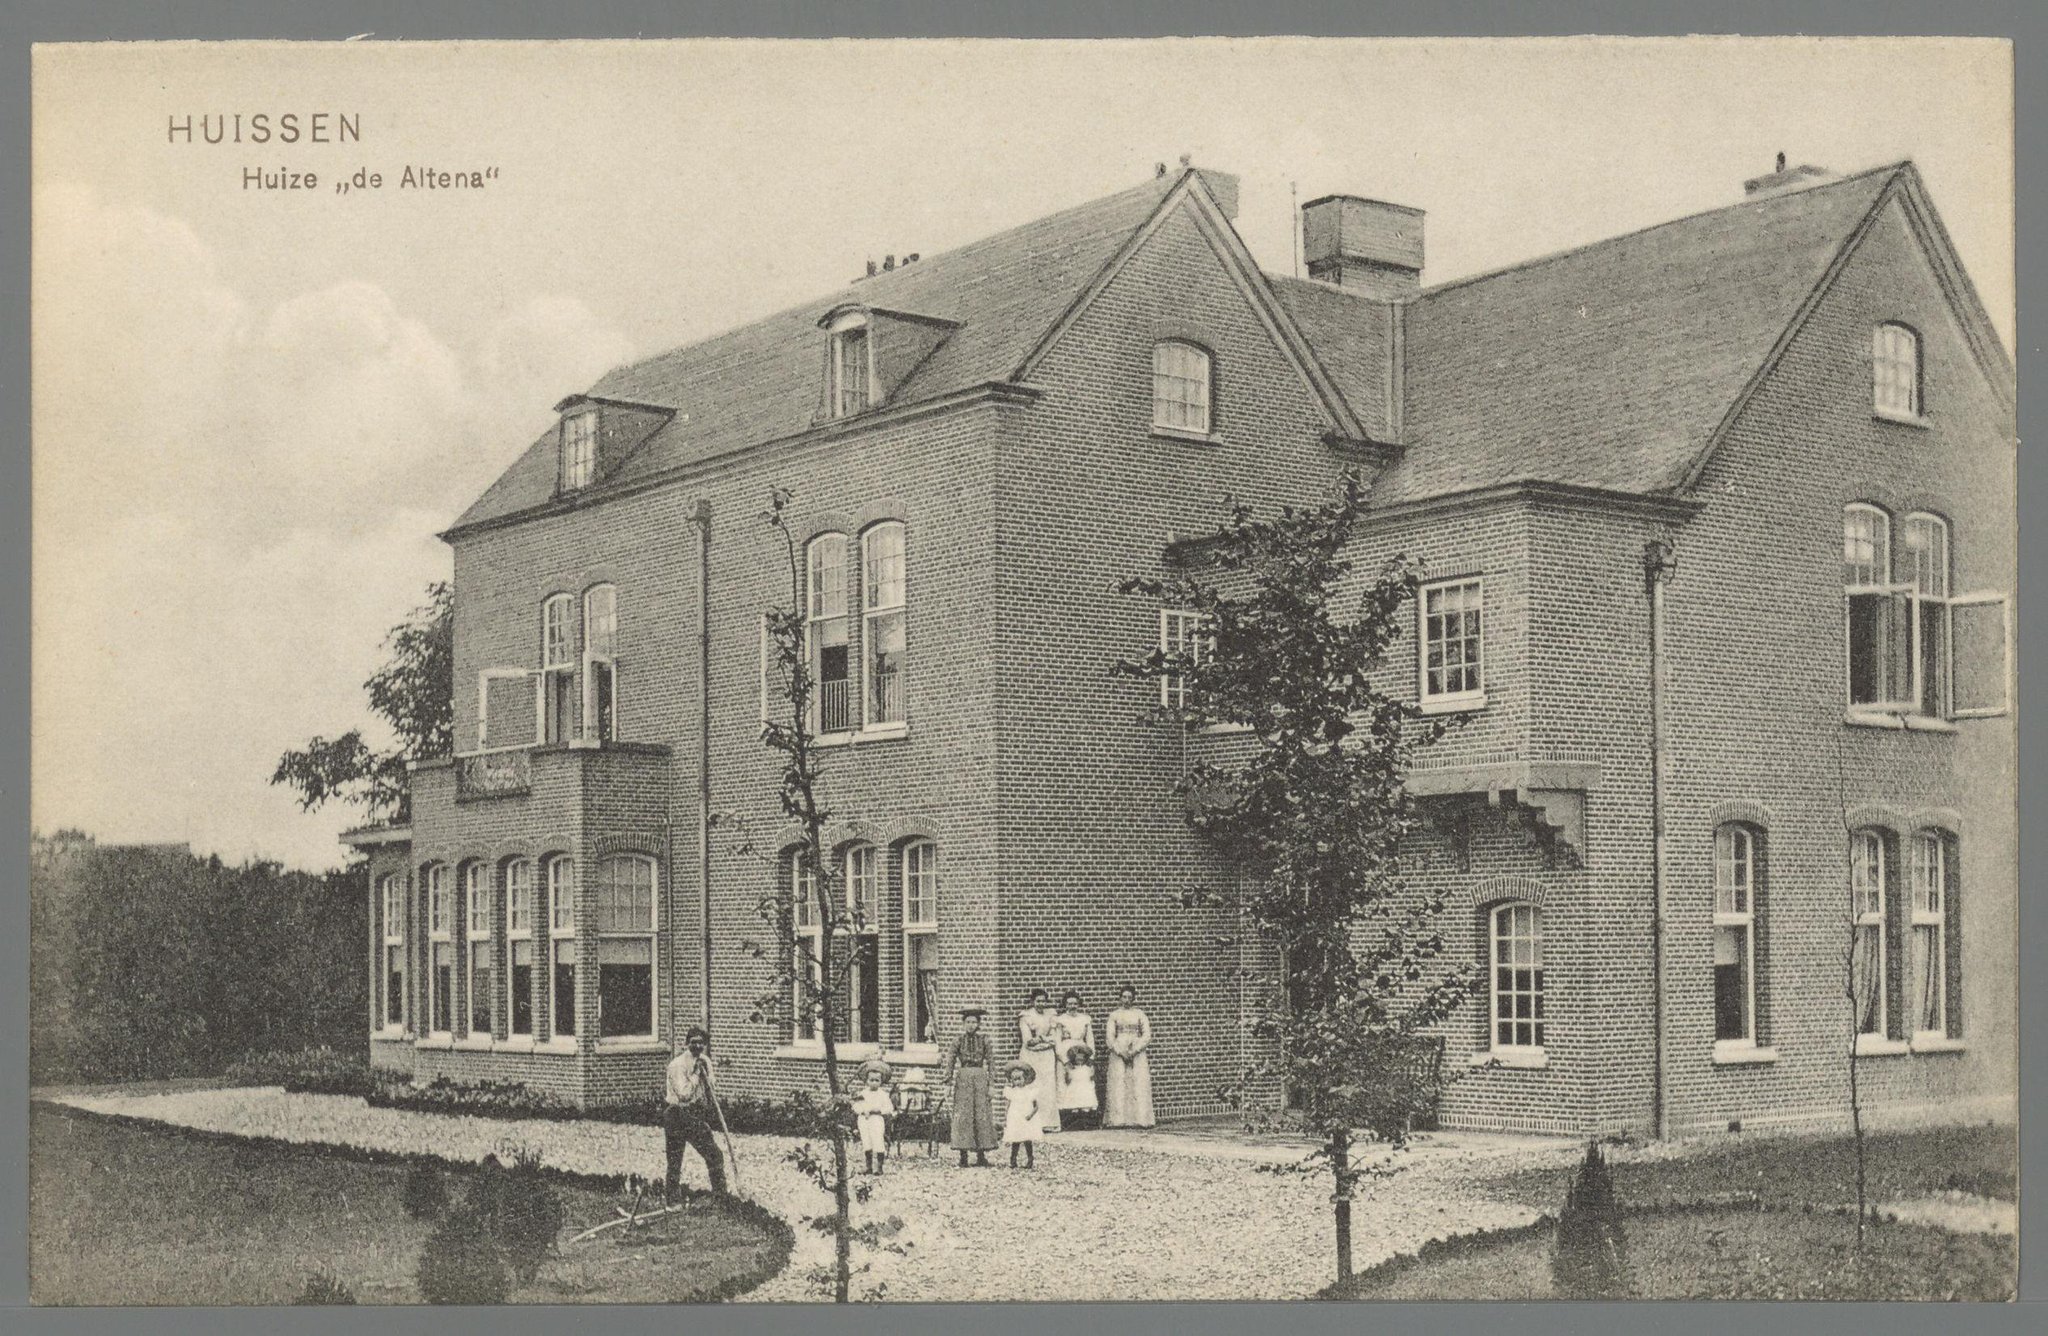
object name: photomechanical print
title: Huissen. Huize "de Altena"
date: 1908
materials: cardboard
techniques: photograph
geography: huissen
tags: villa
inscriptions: date